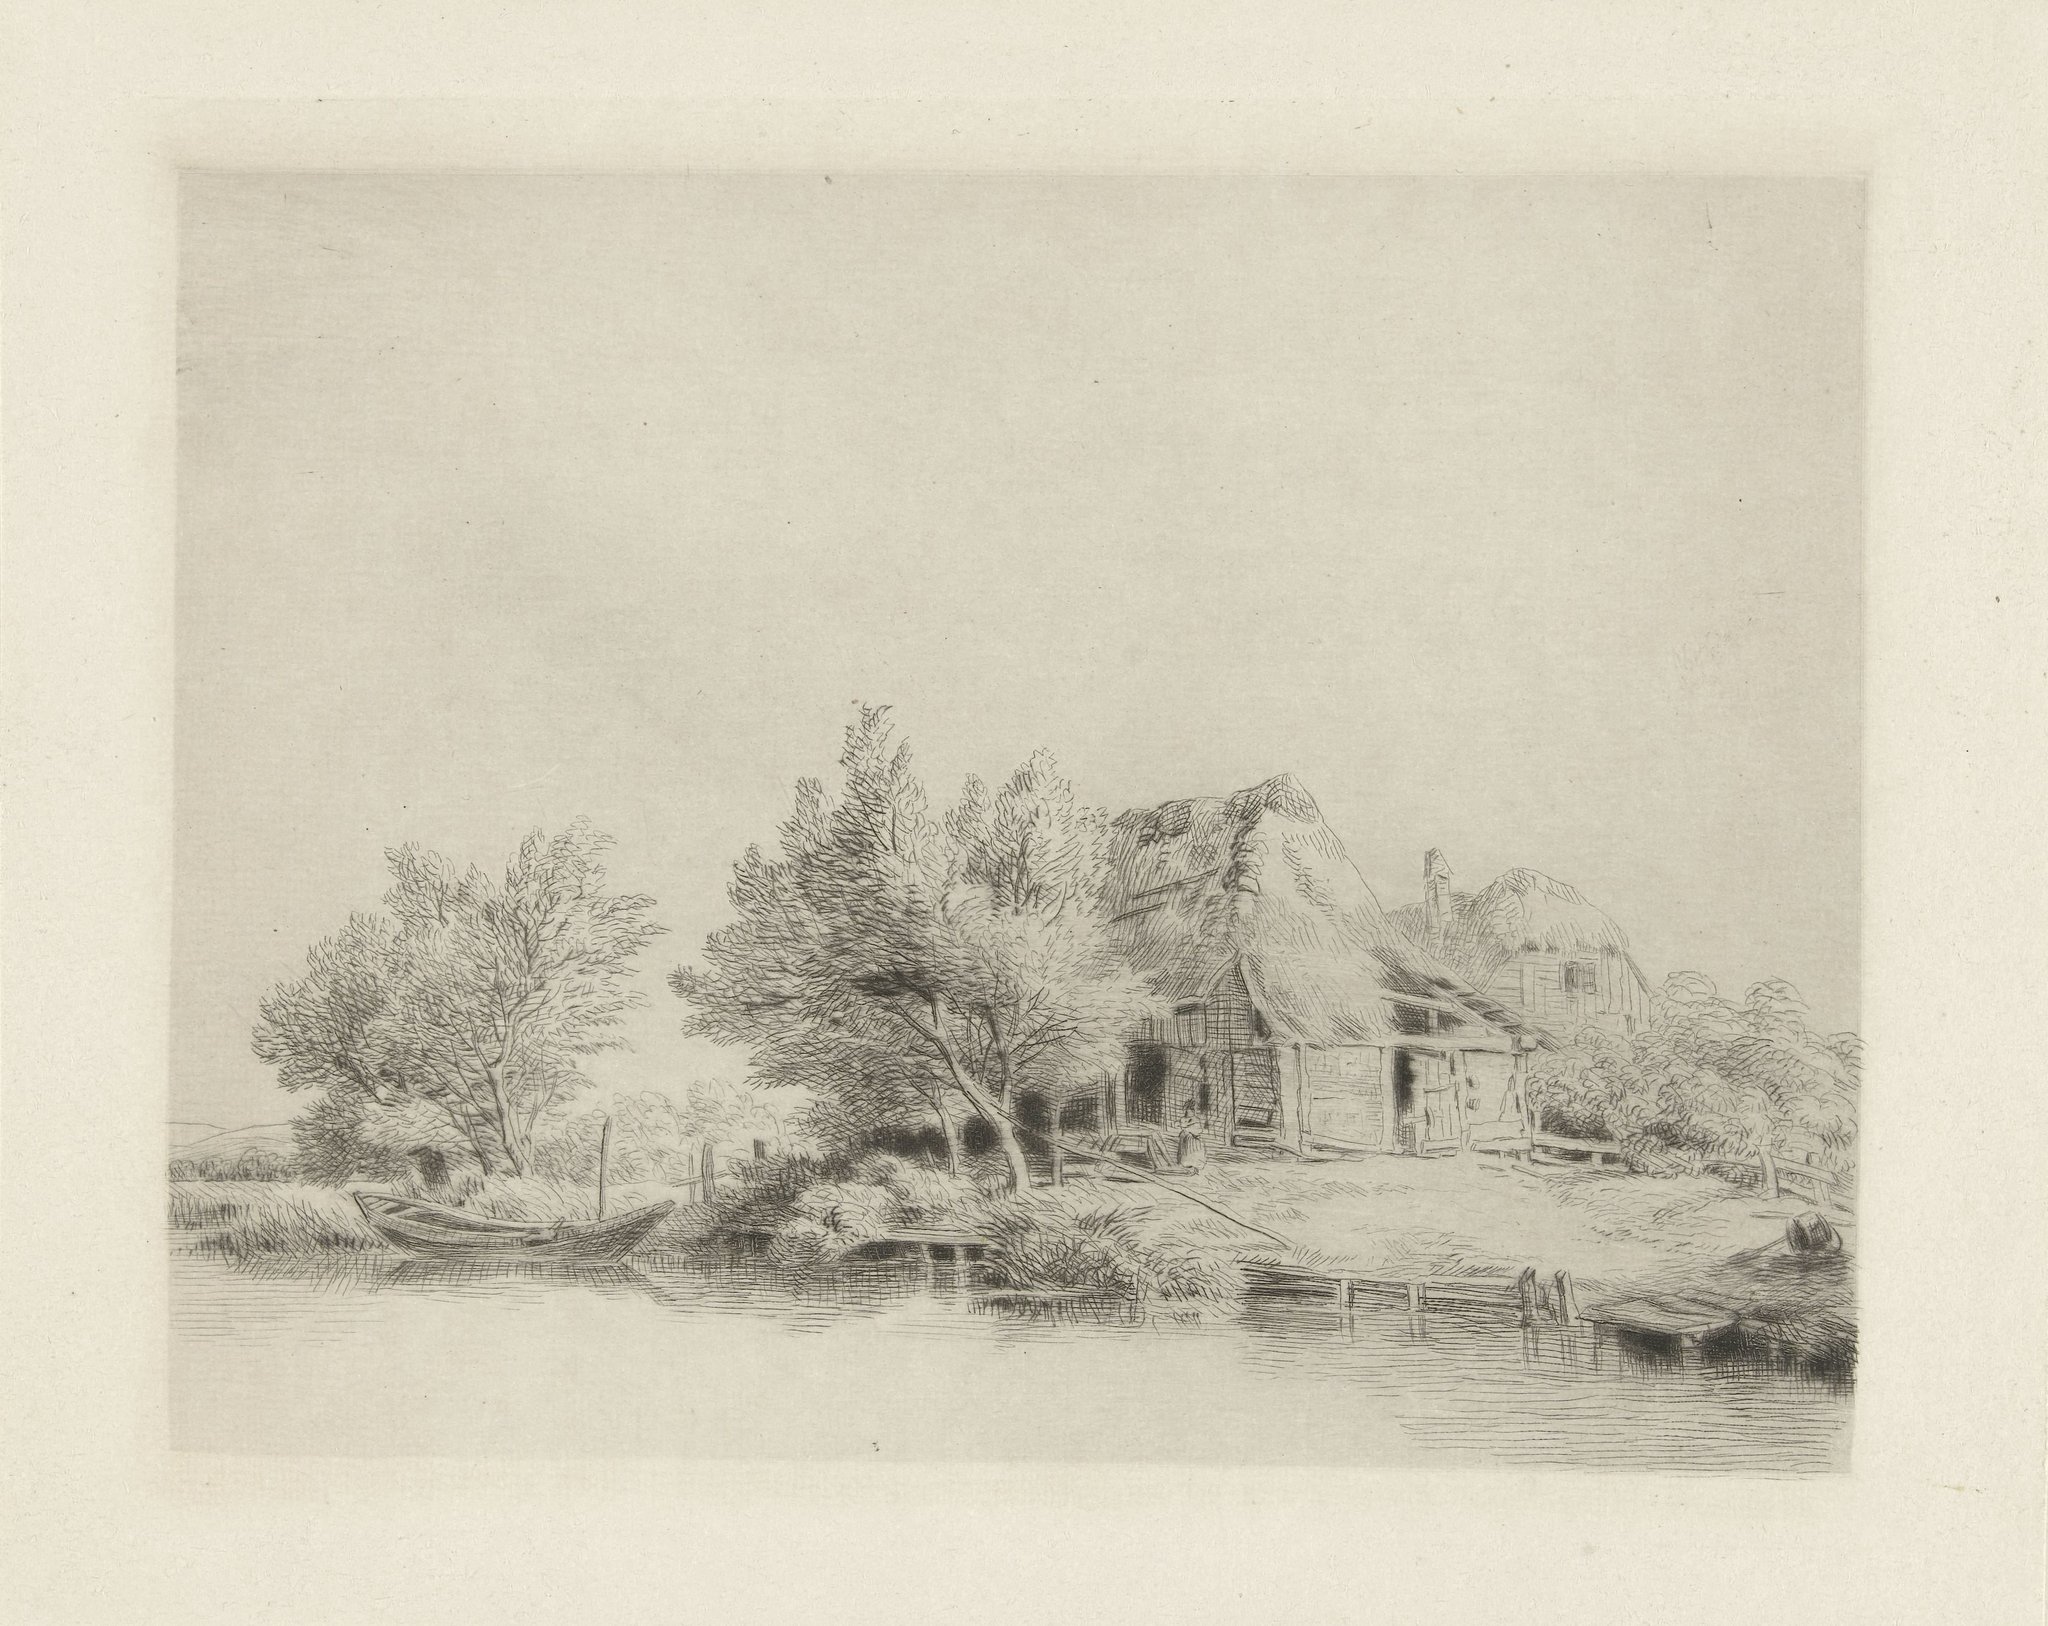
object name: print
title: Vrouw bij een boerderij aan een plas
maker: remigius adrianus haanen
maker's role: draughtsman, painter, print maker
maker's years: 1812-1894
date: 1827-1879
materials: paper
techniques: drypoint, etching, intaglio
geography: austria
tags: farm or solitary house in landscape (+ city(-scape) with figures, staffage)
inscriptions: collector's mark: Lugt 2228